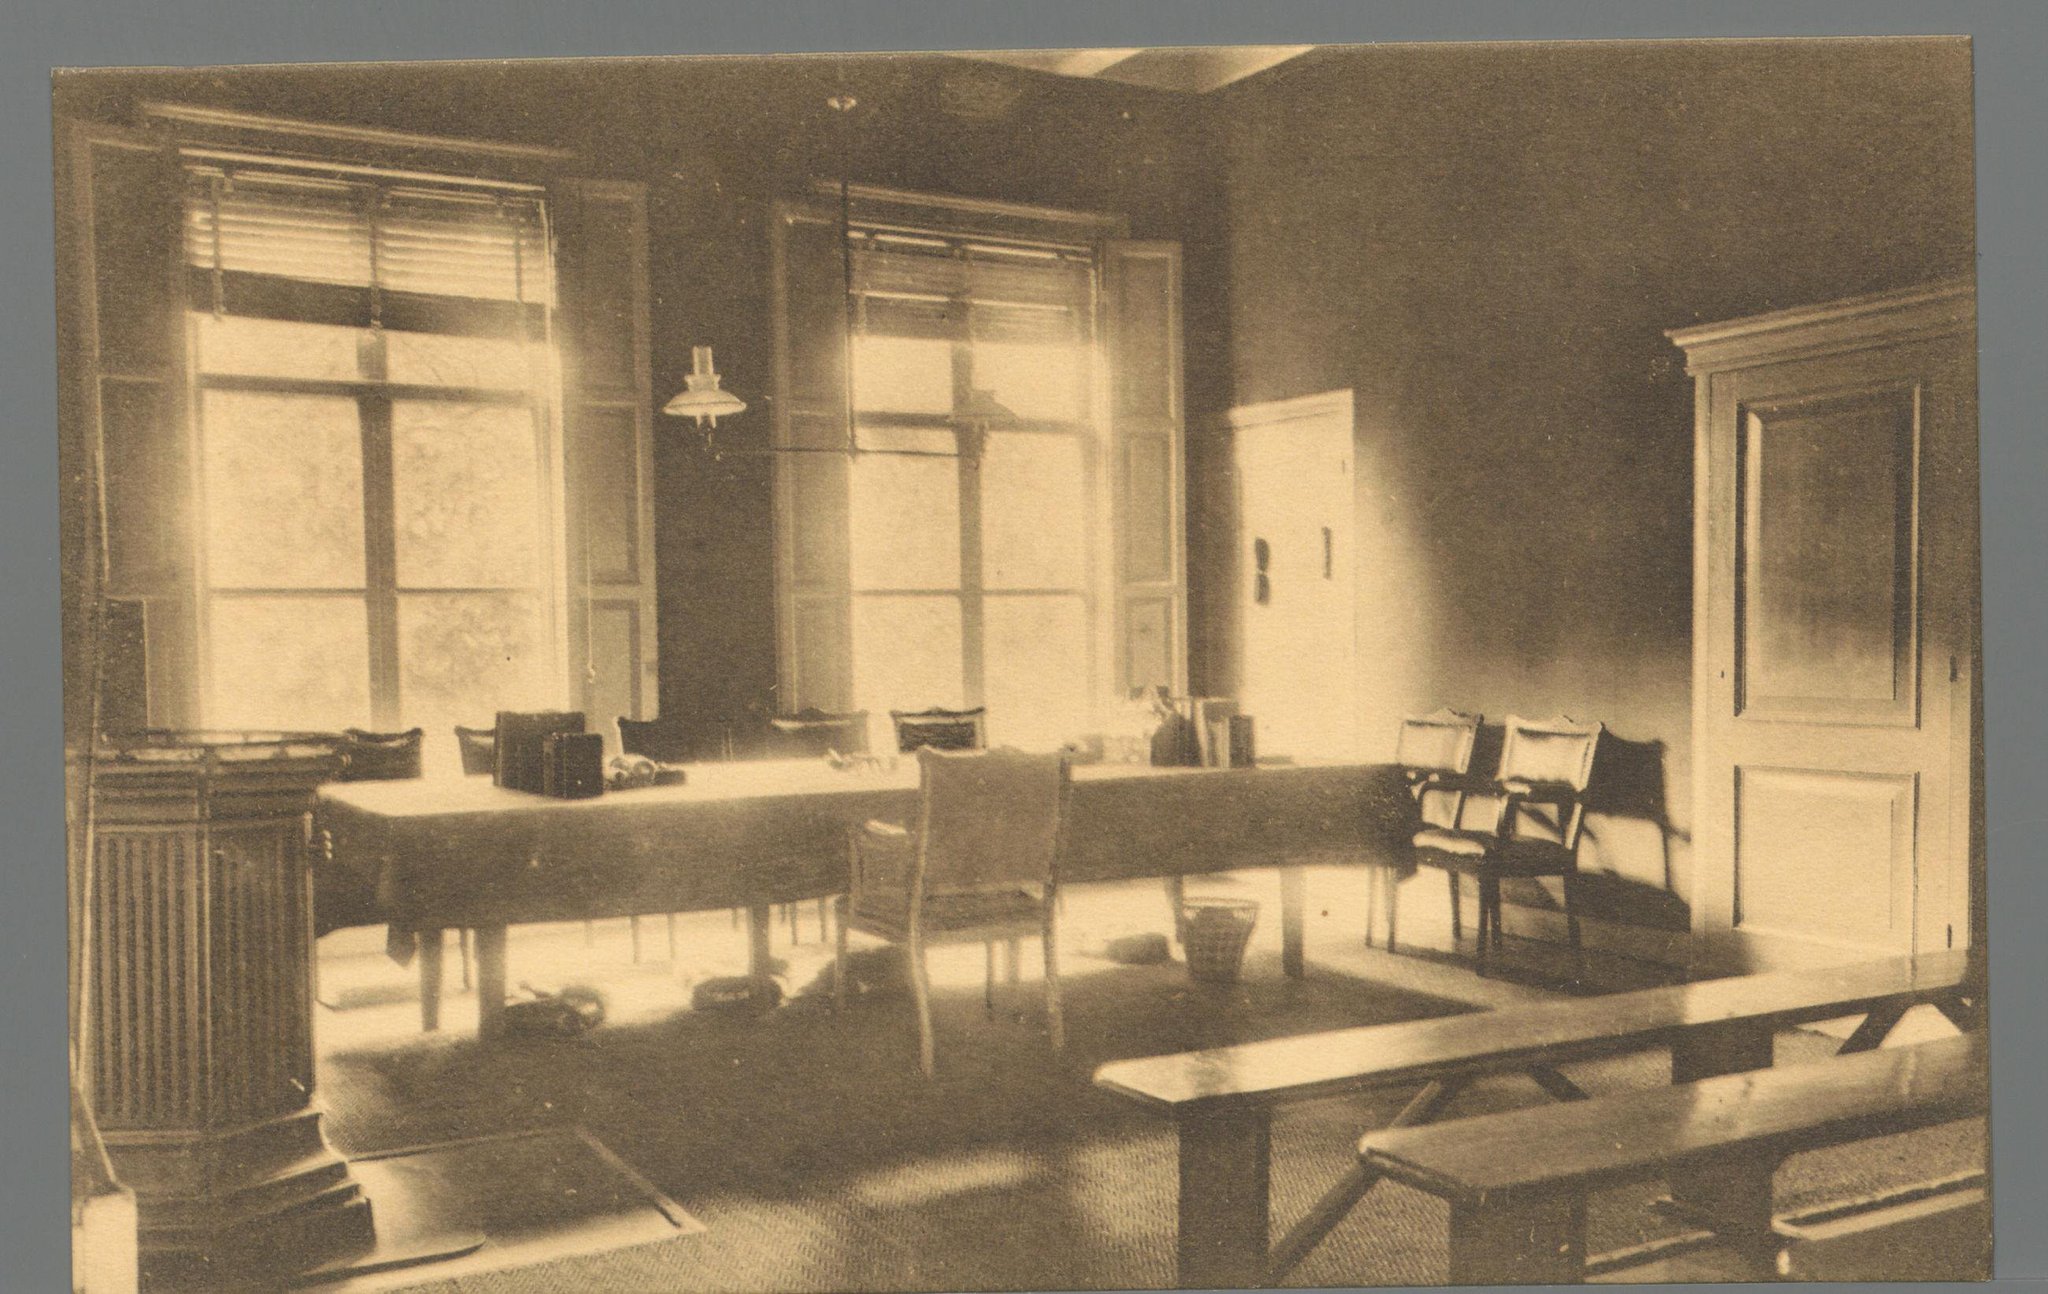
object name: ansichtkaart, prentbriefkaart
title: Leiden. Juridische Collegekamer. Rapenburg No. 25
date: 1905-1930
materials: cardboard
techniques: photograph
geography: leiden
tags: university building, college, leiden